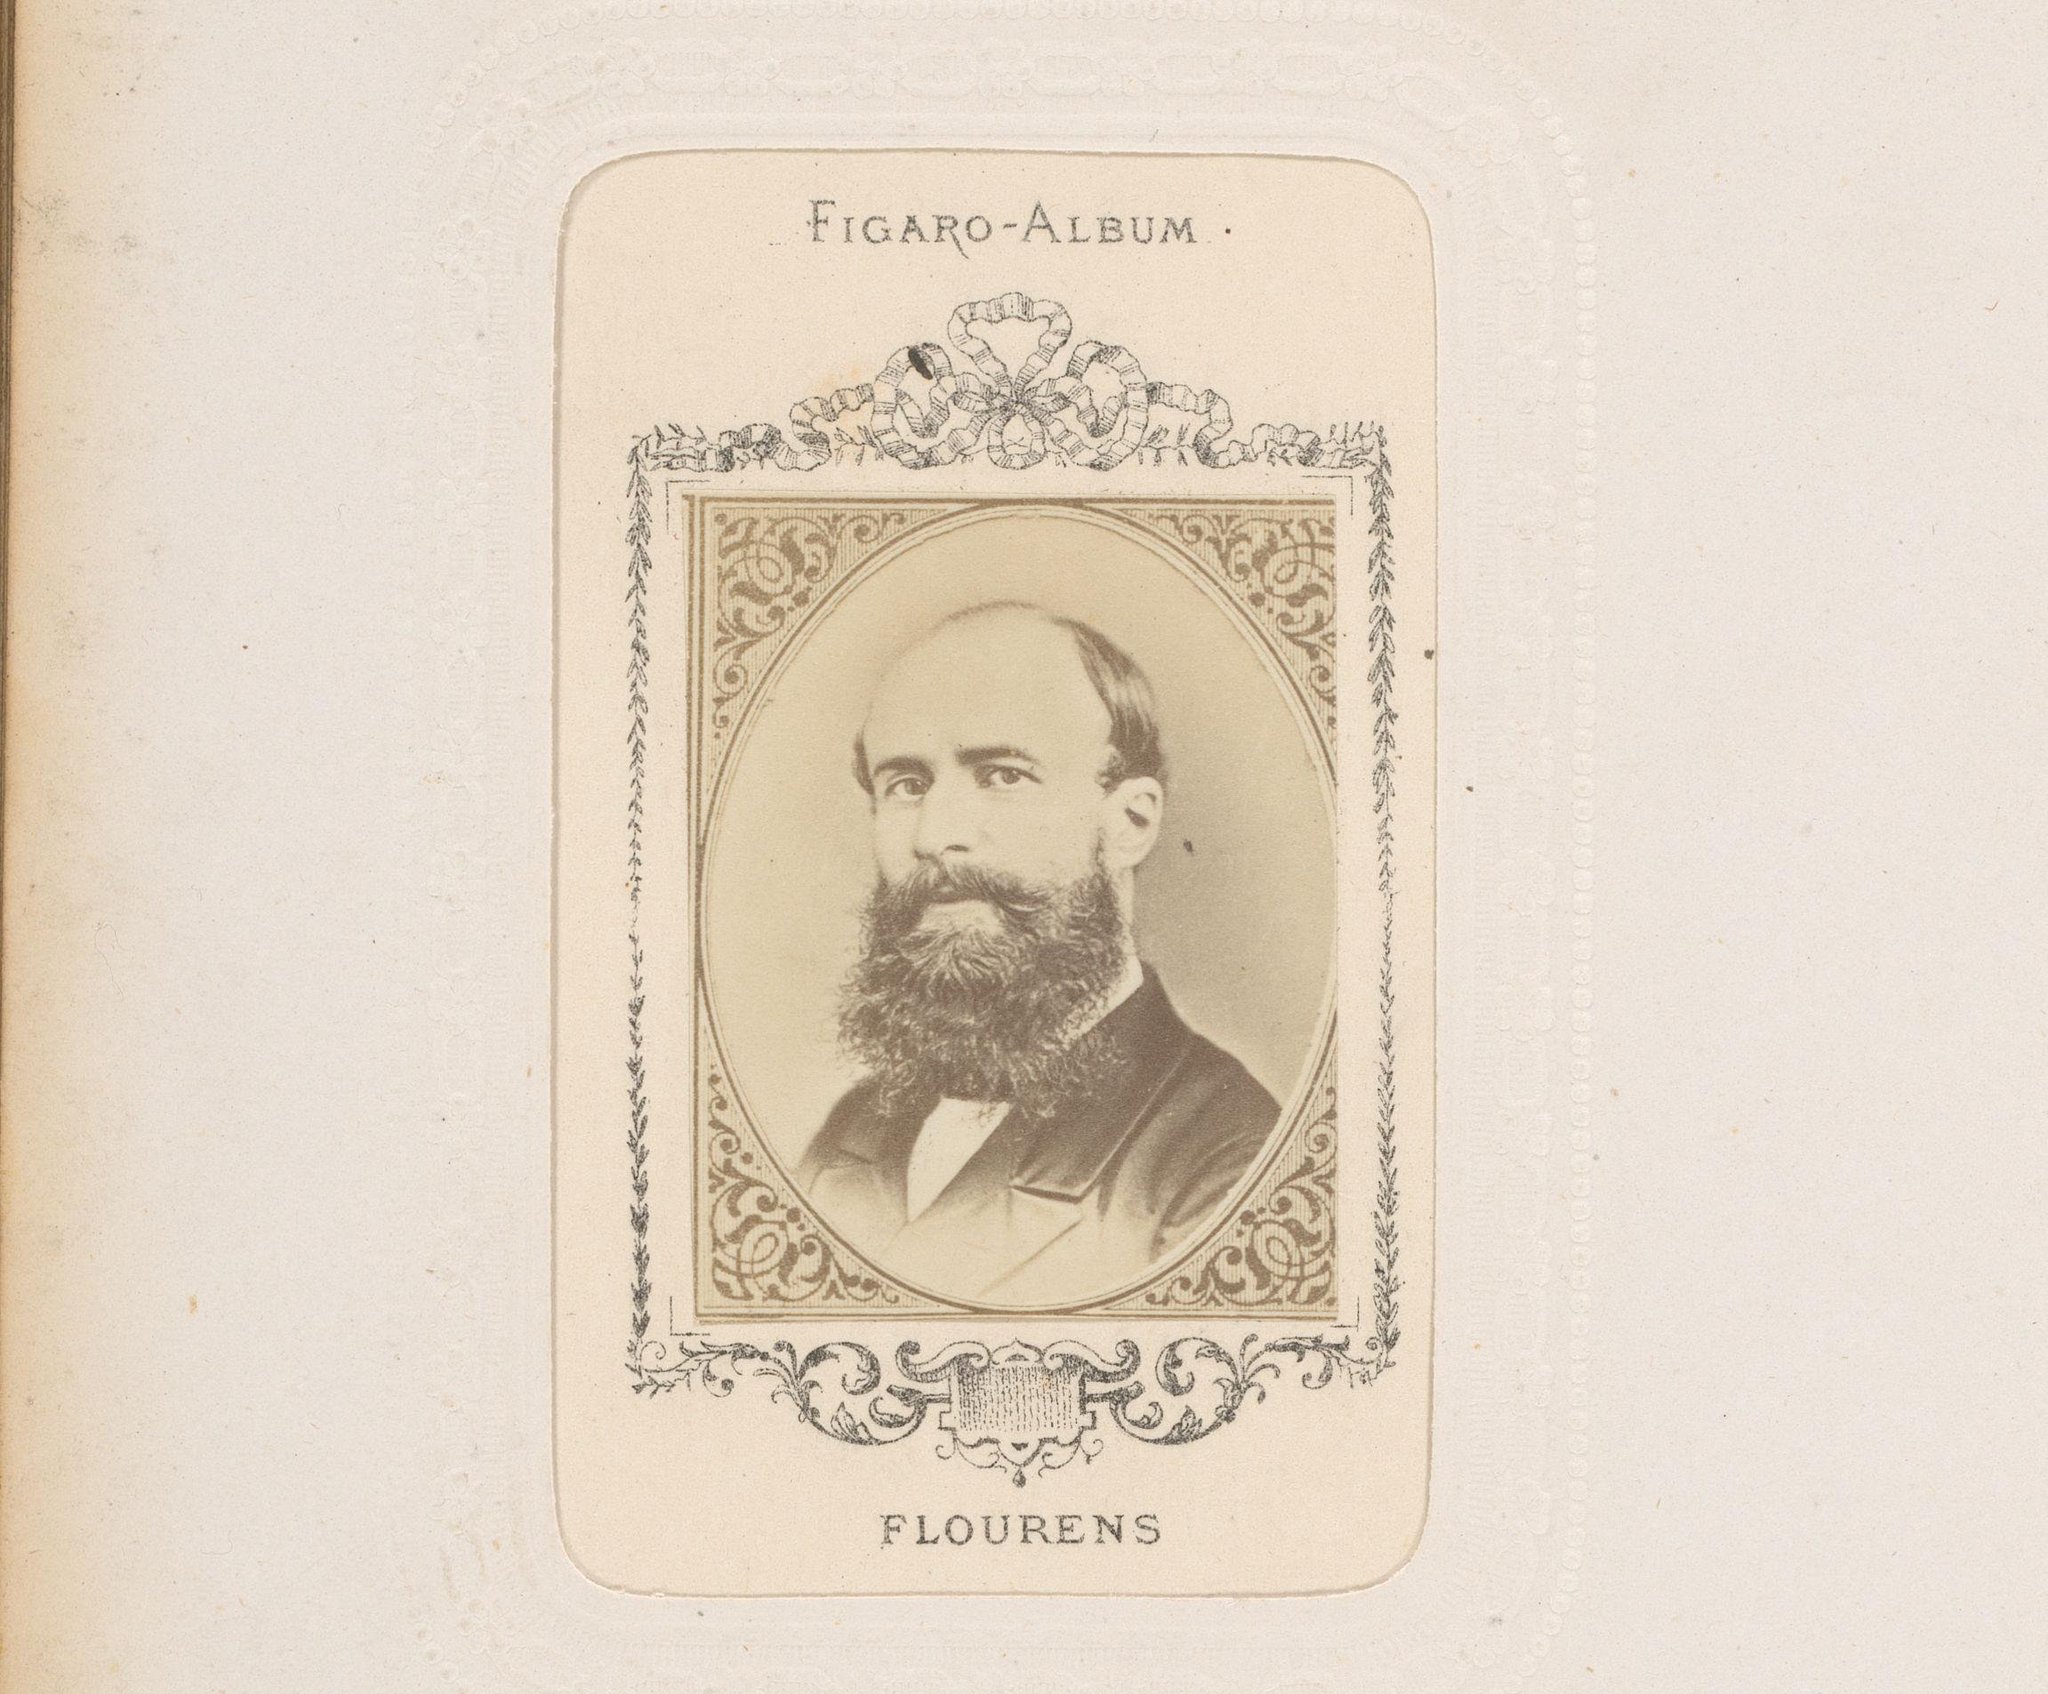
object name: reproduction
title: Fotoreproductie van een portret van Gustave Flourens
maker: Anonymous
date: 1860-1900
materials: cardboard, photographic support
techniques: albumen print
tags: paris, politician, historical persons, politician, e.g. party leader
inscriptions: inscription: ‘Figaro-Album/ Flourens/ d'après Bacard Fils Phot.’